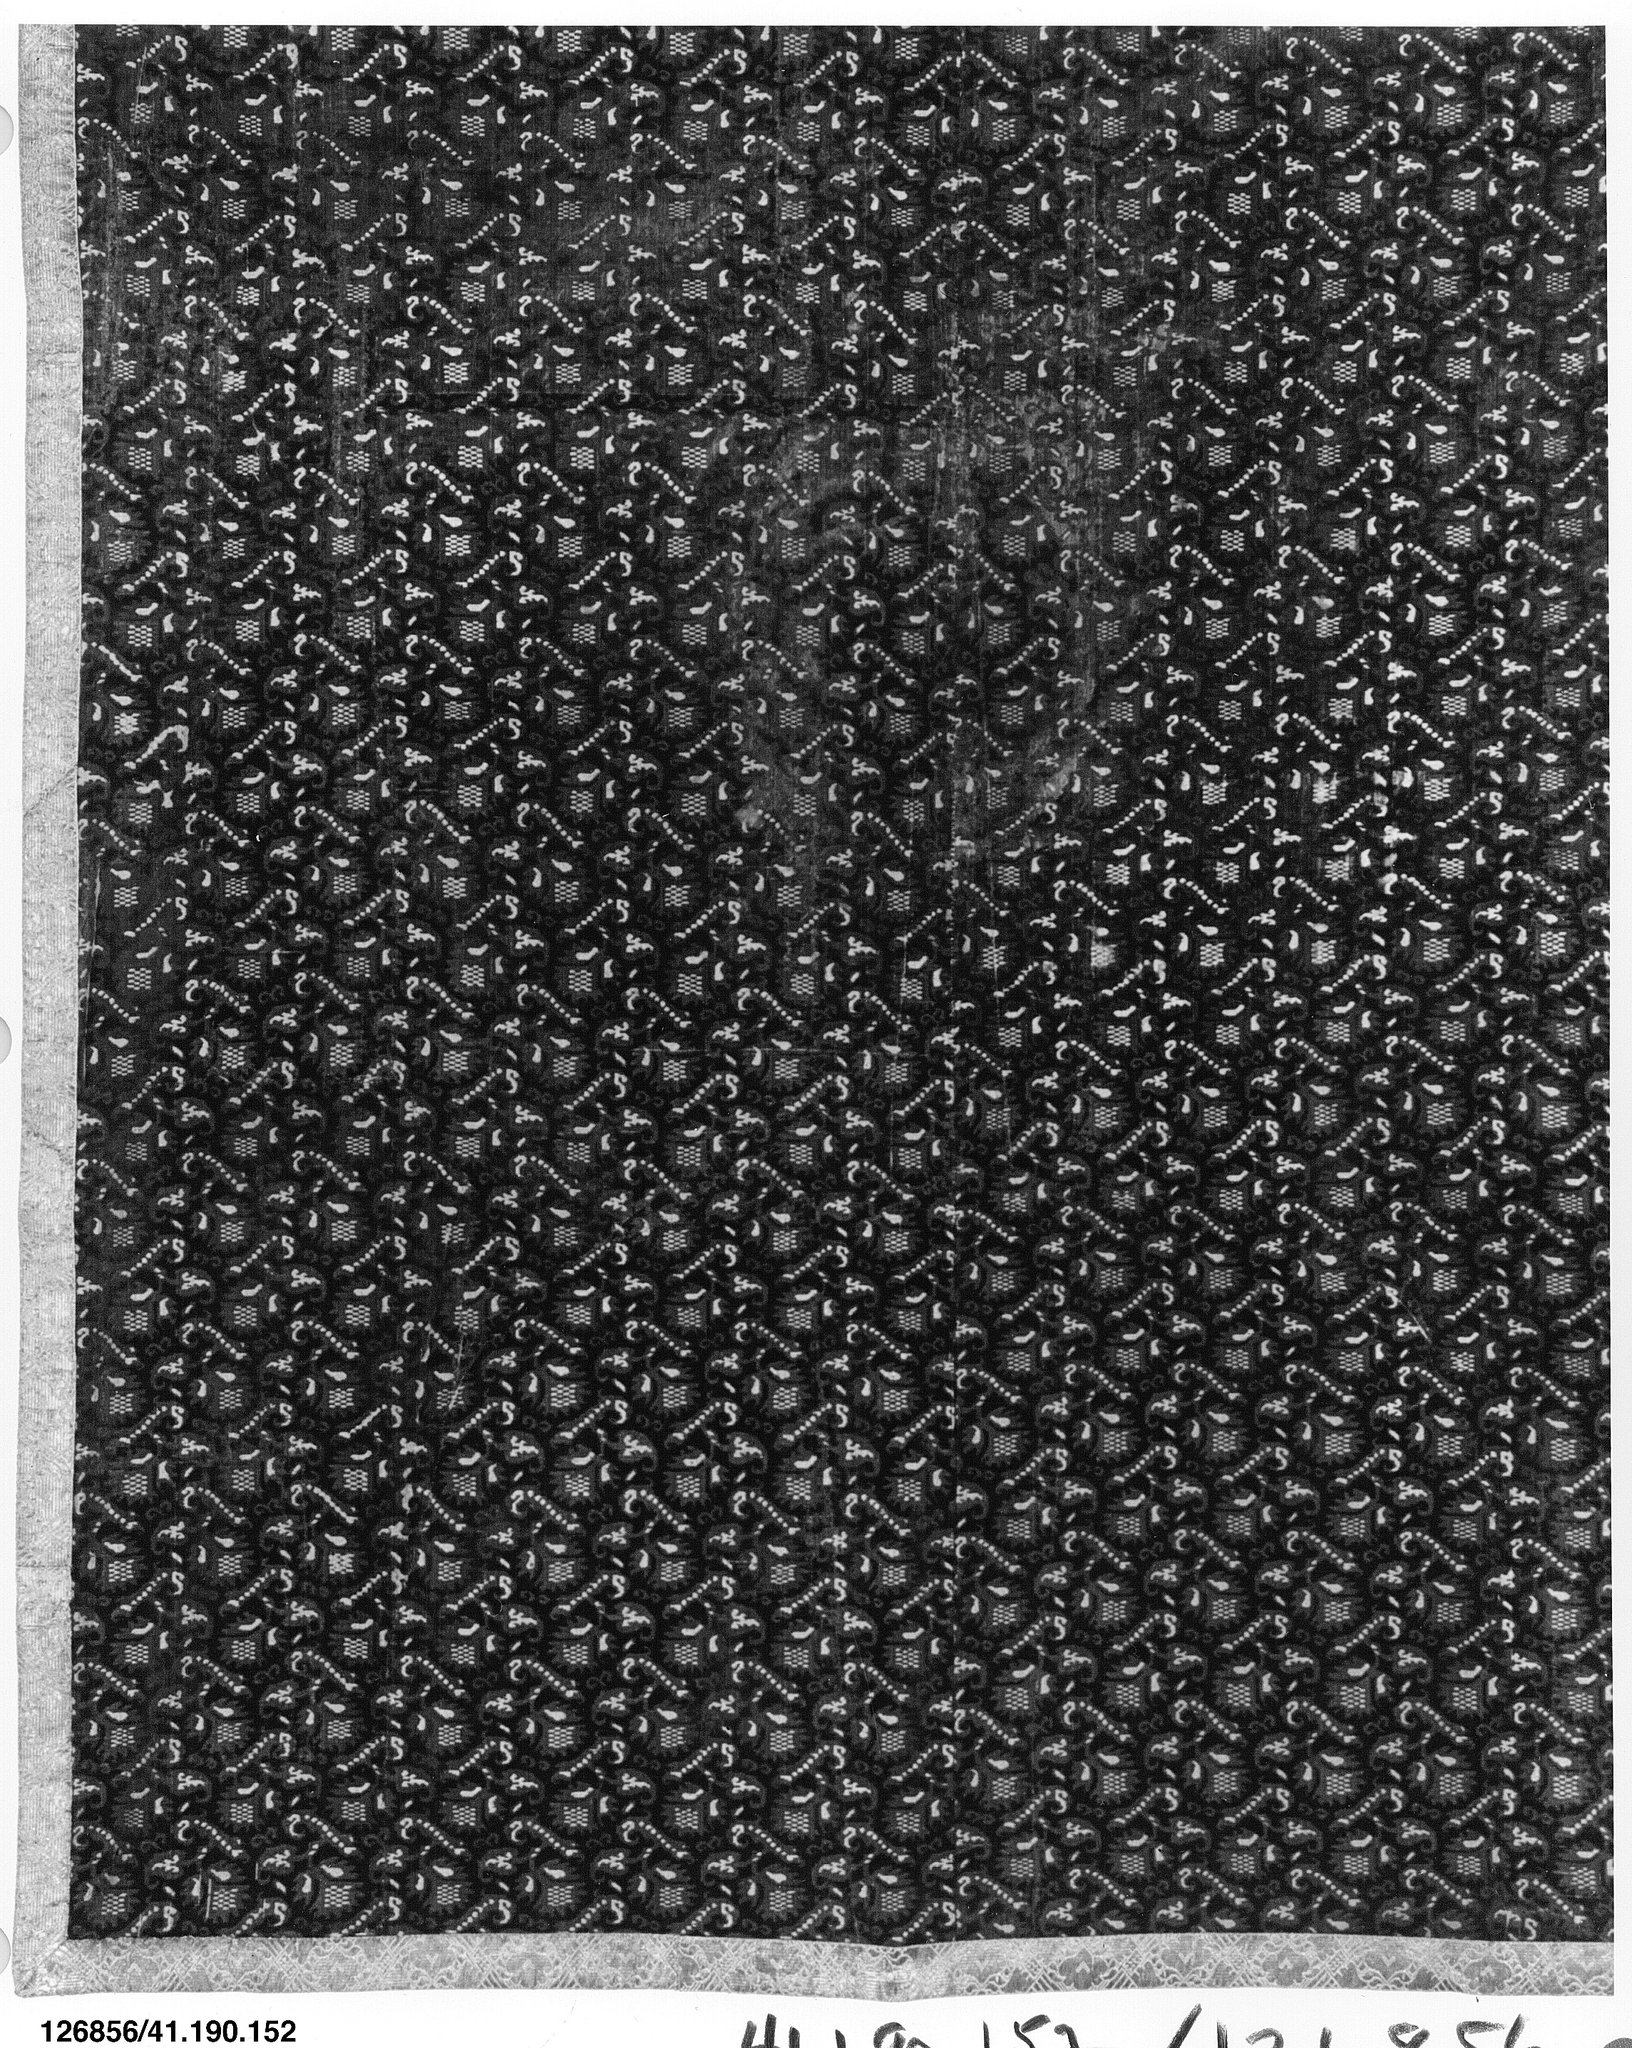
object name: panel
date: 1601-1650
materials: silk